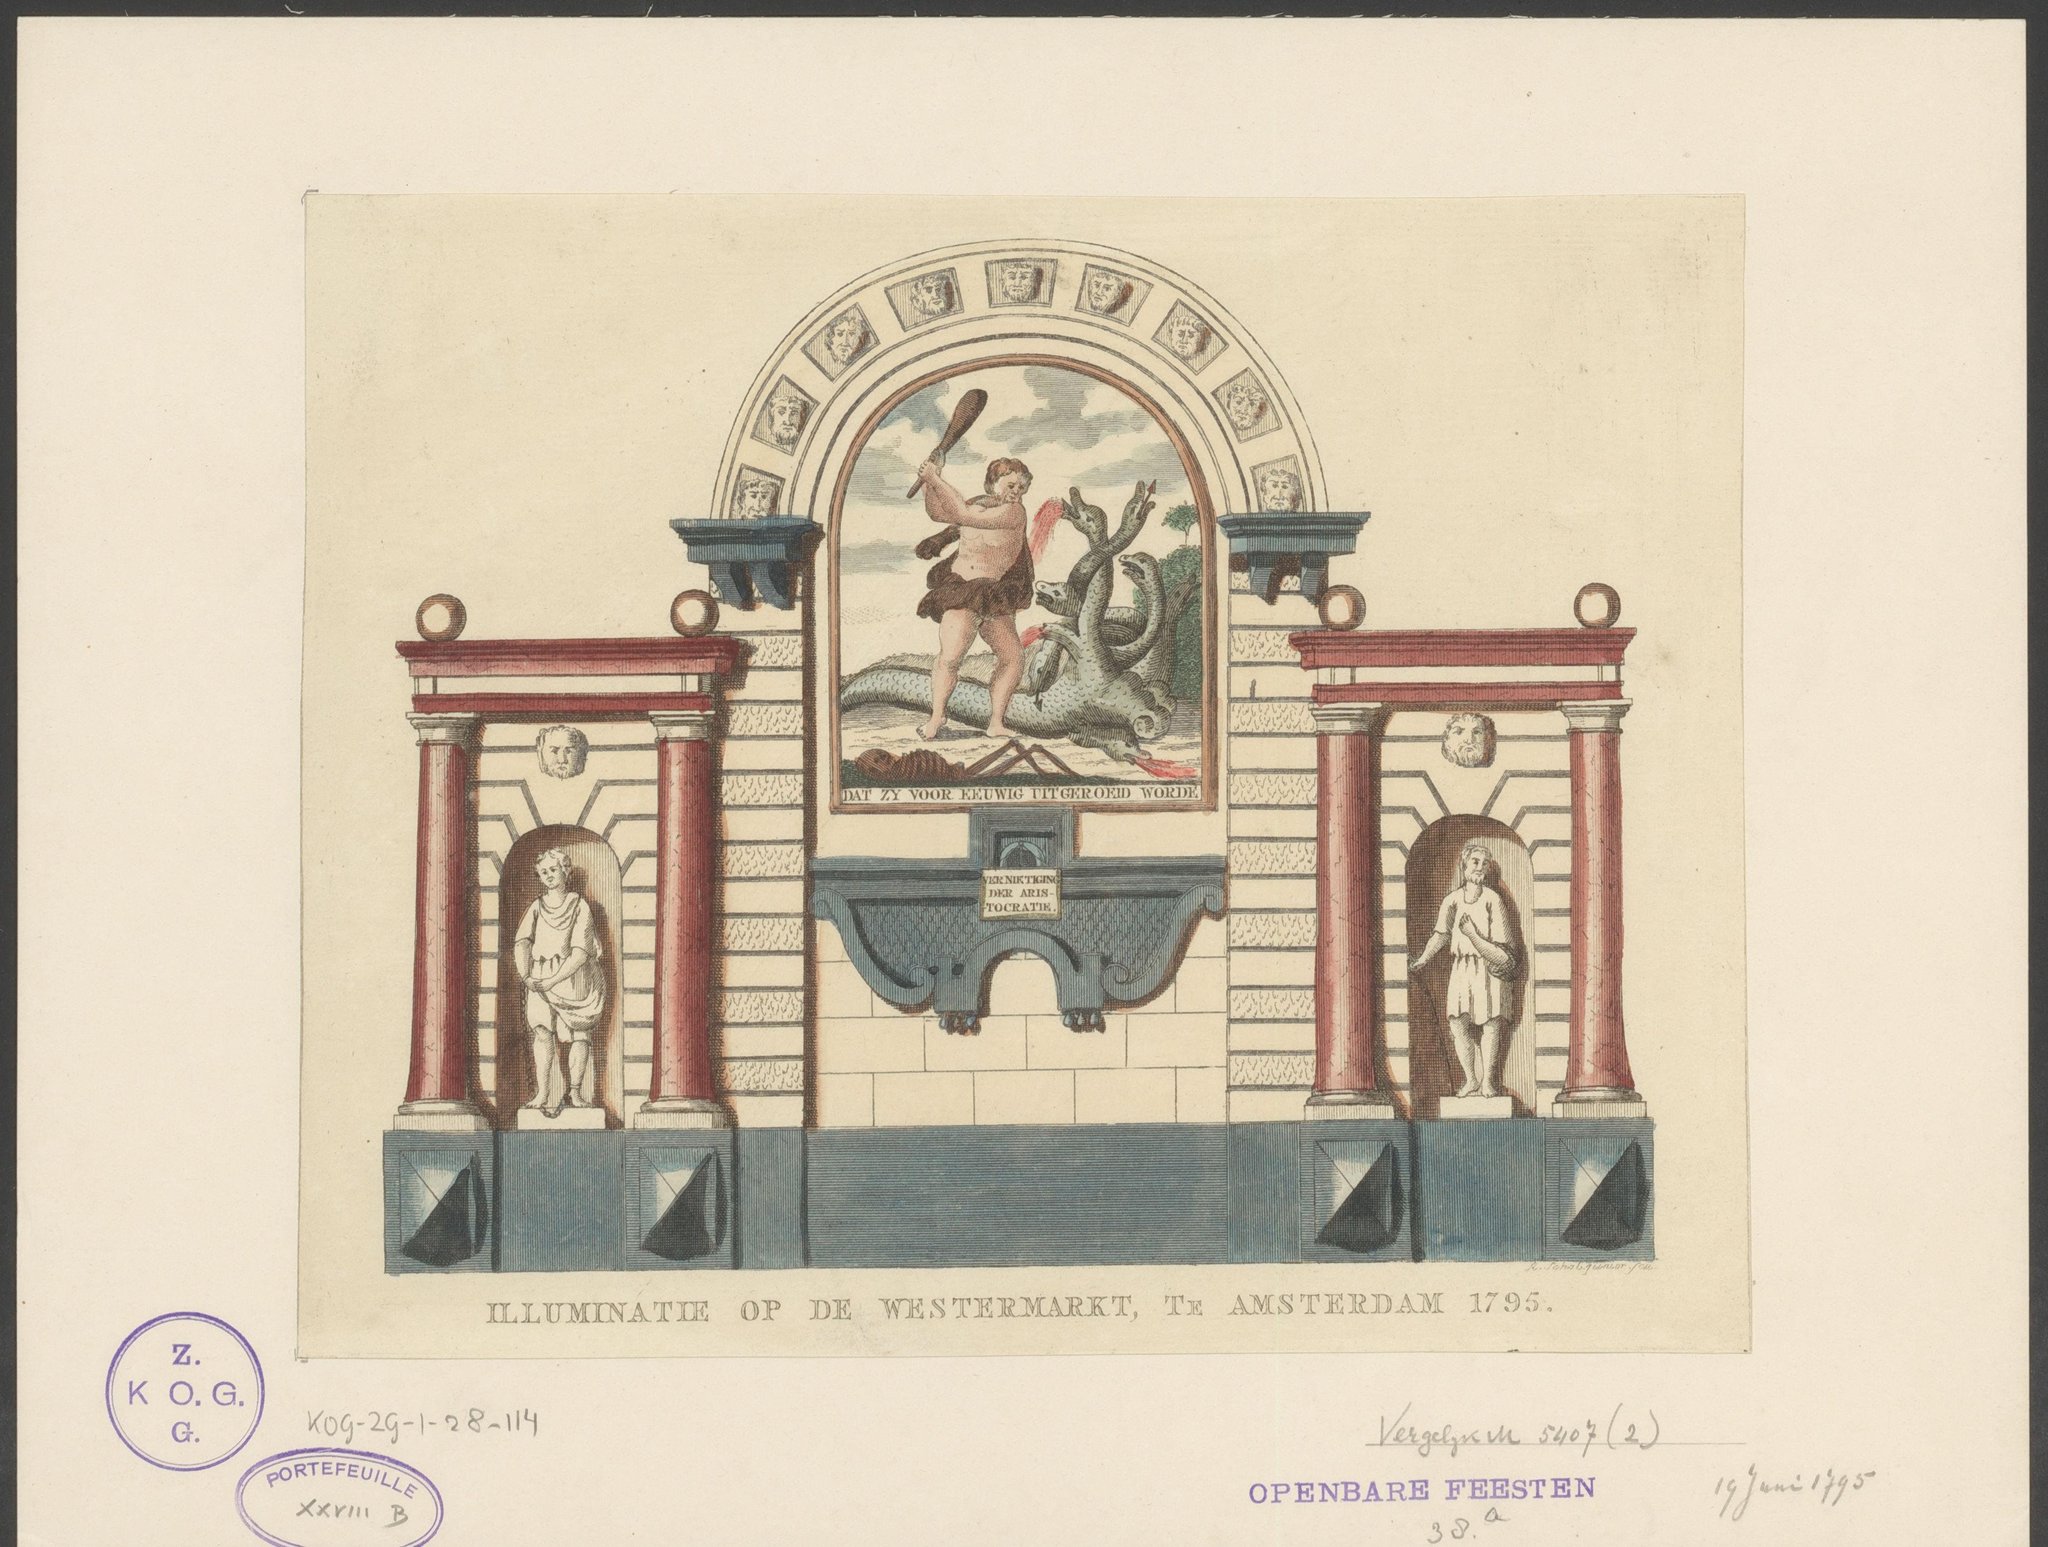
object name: print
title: Vernietiging der Aristocratie, decoratie op de Westermarkt, 1795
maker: a. schol (ii)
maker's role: print maker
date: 1795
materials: paper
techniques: etching, hand coloring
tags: (2) the hydra of lerna is killed by hercules, festivities on events of national importance (+ festive decoration ~ festive activities), amsterdam, alliance with france (1795)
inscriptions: stamp, collector's mark: Lugt 1641, stamp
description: De Vernietiging der Aristocratie, allegorische decoratie opgericht op de Westermarkt te Amsterdam bij het Alliantiefeest op 19 juni 1795. Hercules (het Nederlandse volk) verslaat de zevenkoppige hydra (aristocratie en familieregering). Onderdeel van een serie van dertien platen. Onderwerpsrubrieken binnen de Atlas Zeden en Gewoonten: Zeden en Gewoonten in Engeren Zin. Volksleven. Openbare feesten. Vorstelijke intochten, (Illuminaties, vuurwerken en dergelijke, openbare feesten).